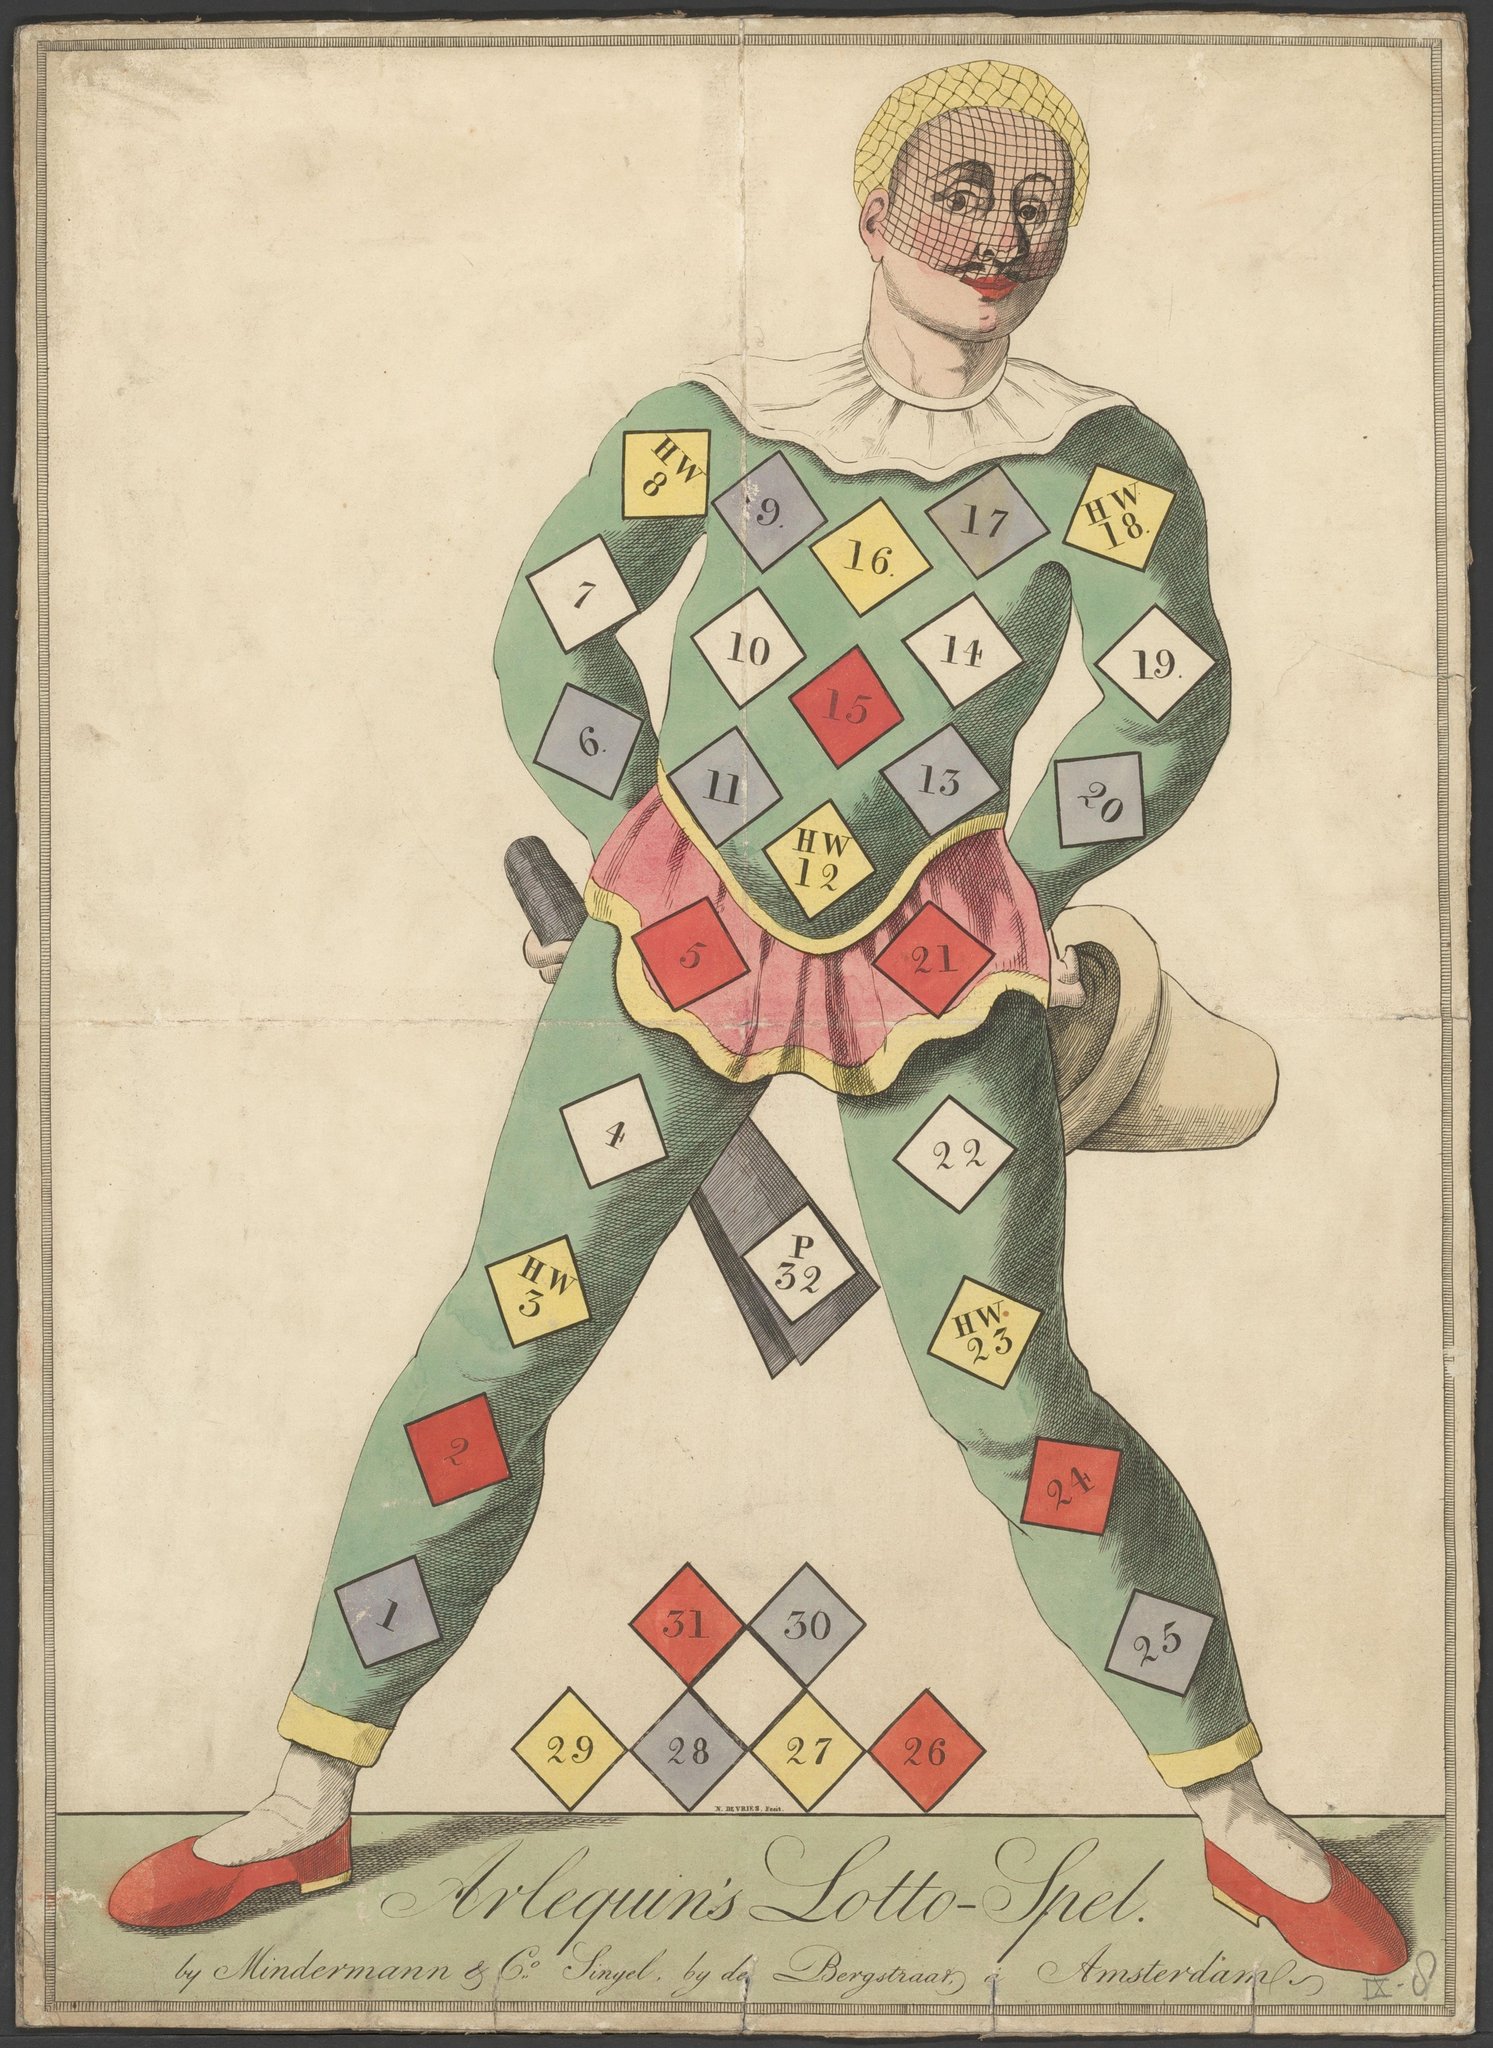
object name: print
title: Arlequin's Lotto-Spel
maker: n. de vries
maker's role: print maker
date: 1818-1845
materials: cardboard, paper, watercolor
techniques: engraving, hand coloring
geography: amsterdam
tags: board-games of chance, types in 'commedia dell'arte': harlequin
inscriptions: collector's mark, collector's mark: Lugt 1641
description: Bordspel in de vorm van een beeldvullende harlekijn in een groen pak staande met gespreide benen en een netje over zijn gezicht. Over zijn lichaam en tussen zijn benen vierkante vakjes genummerd 1 tot en met 32. Onderwerpsrubrieken binnen de Atlas Zeden en Gewoonten: Spel en Vermaak; gezelschapsspel, ganzenbord en dergelijke.